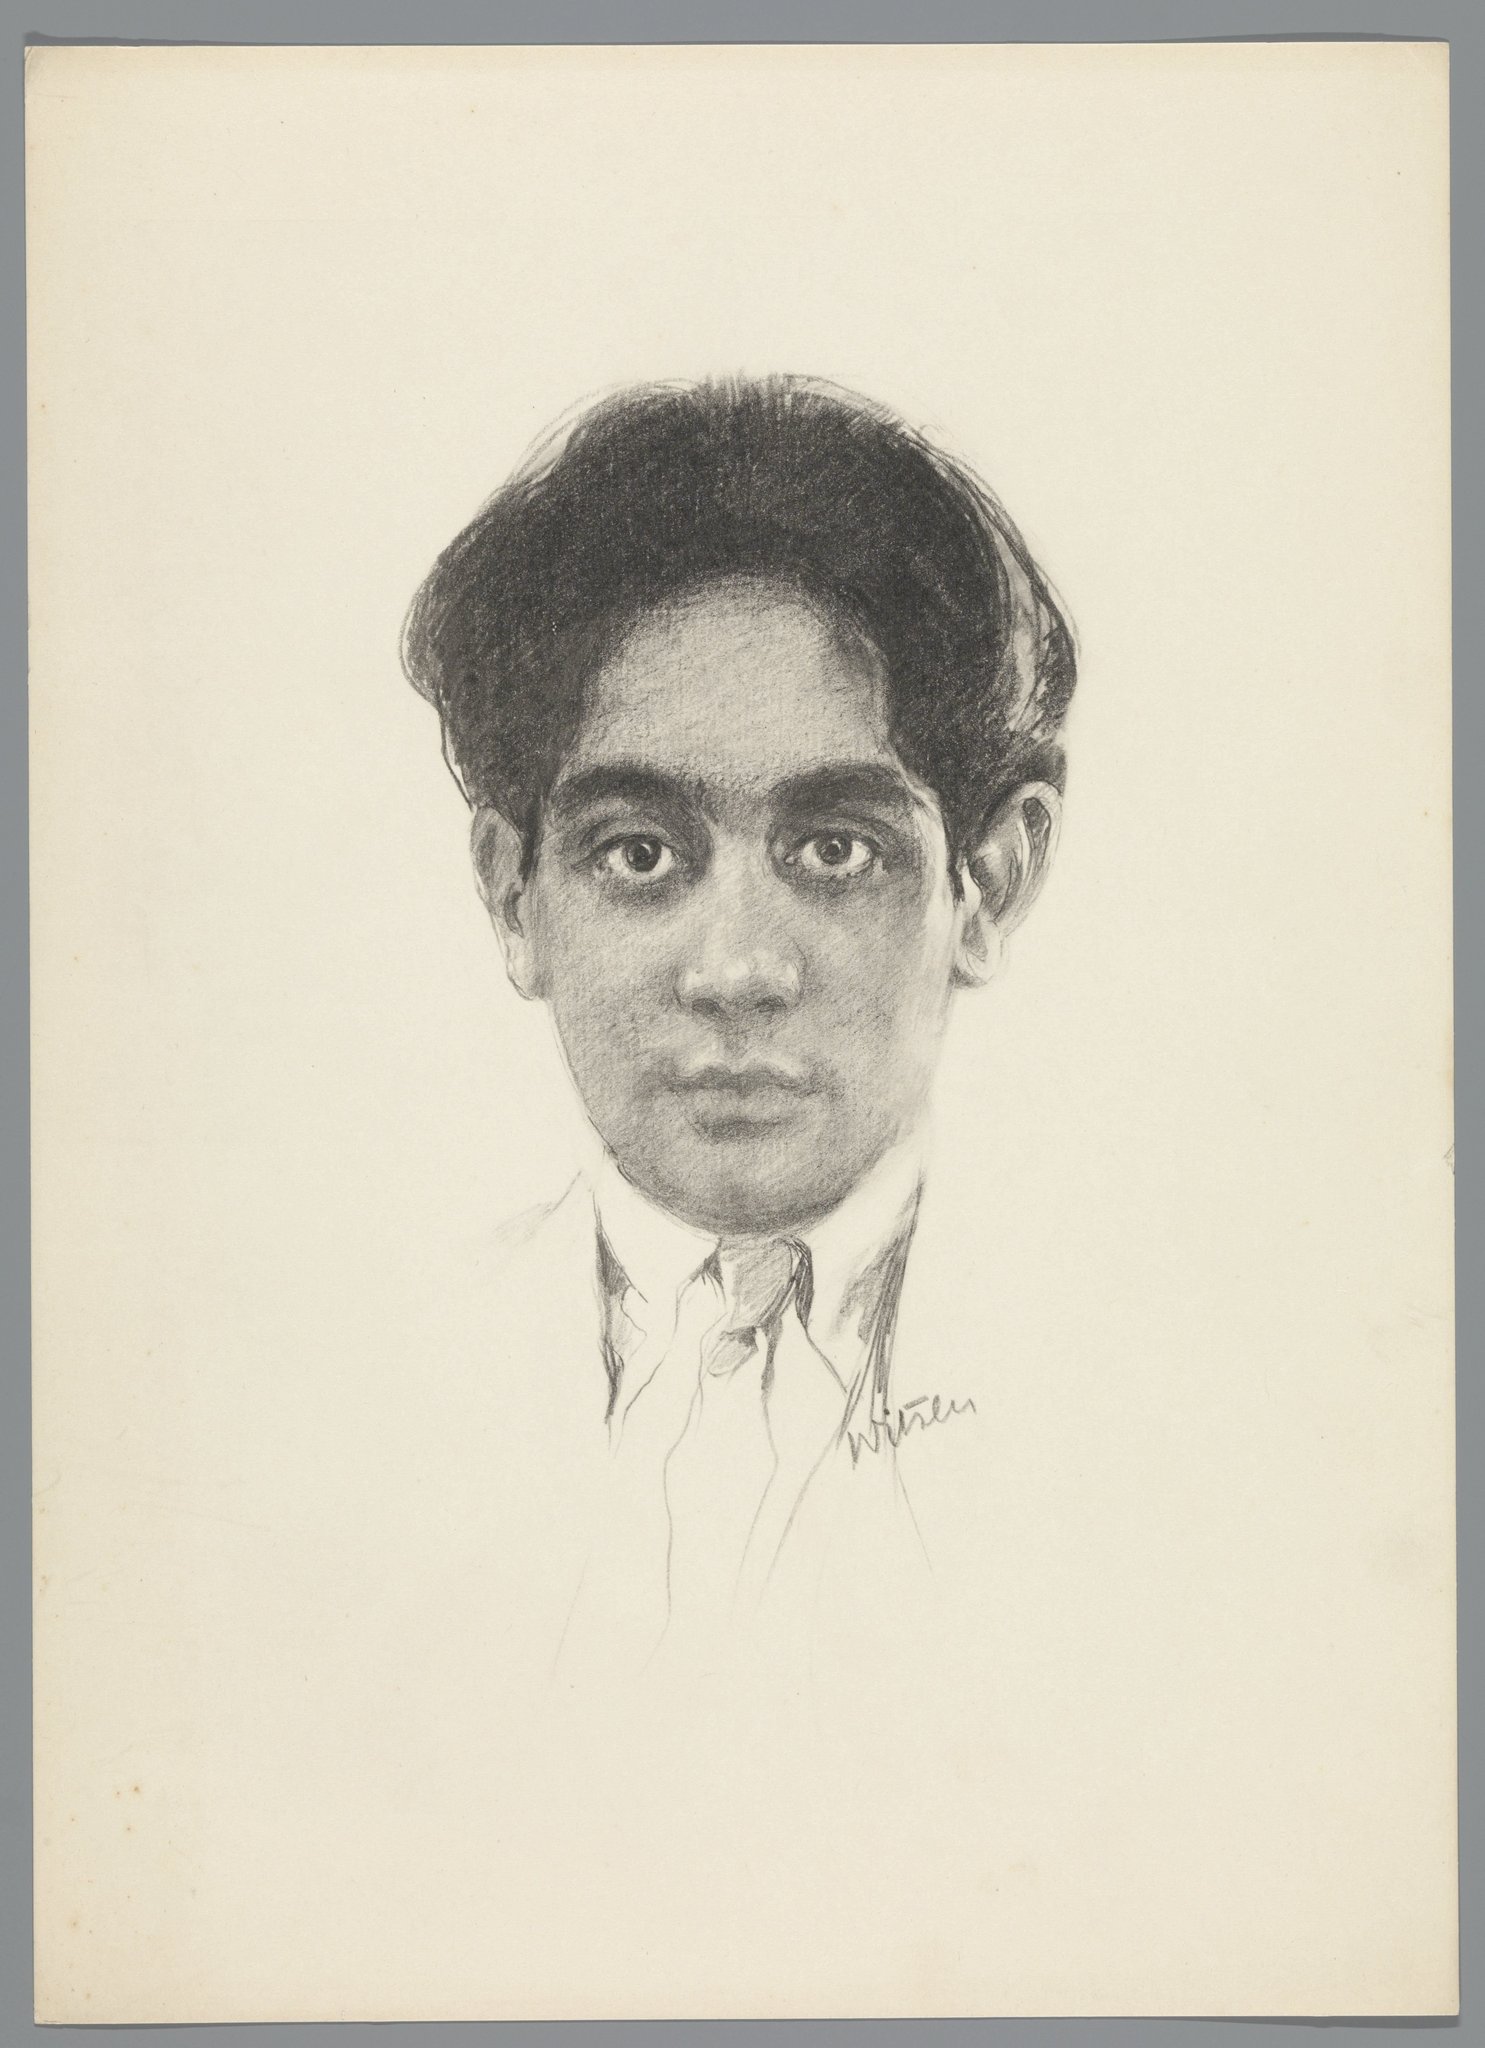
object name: reproduction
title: Reproductie van tekening met portret van Karamjit Singh Sahib Bahadur, prins van Kapurthala, door Willem Witsen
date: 1915-1916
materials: paper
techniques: photograph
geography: netherlands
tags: politician, historical persons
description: Voor schilderij van de geportretteerde door Witsen, zie collectie Dordrechts Museum (bruikleen RCE).